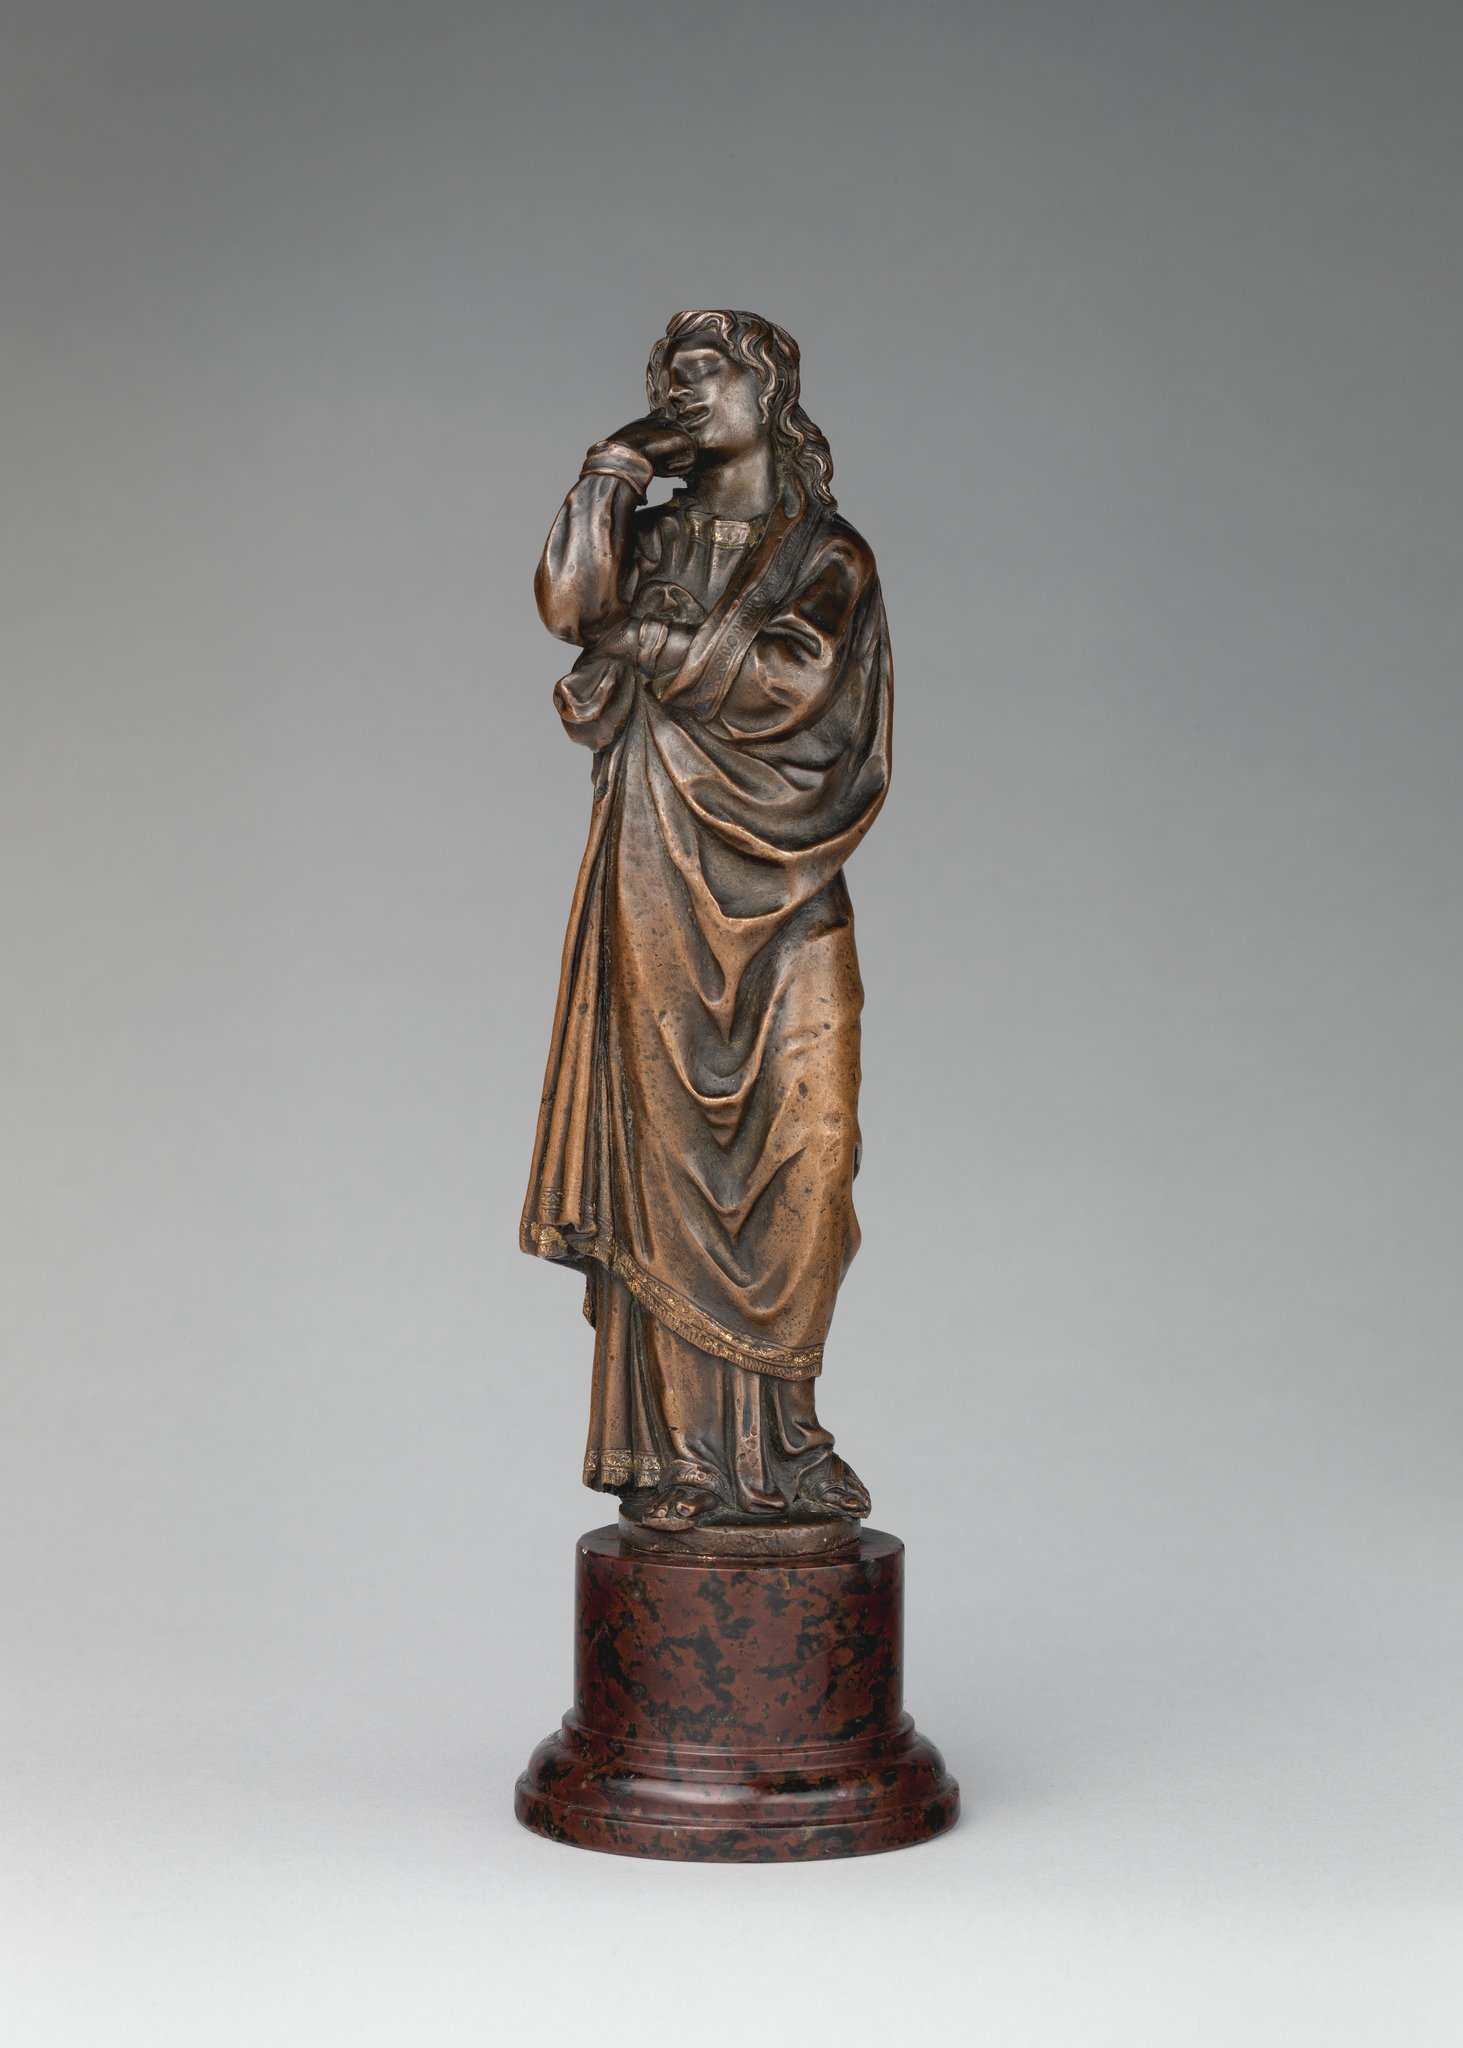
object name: statuette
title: Saint John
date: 1467-1500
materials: bronze, gilt, oil, stone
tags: saint john the baptist